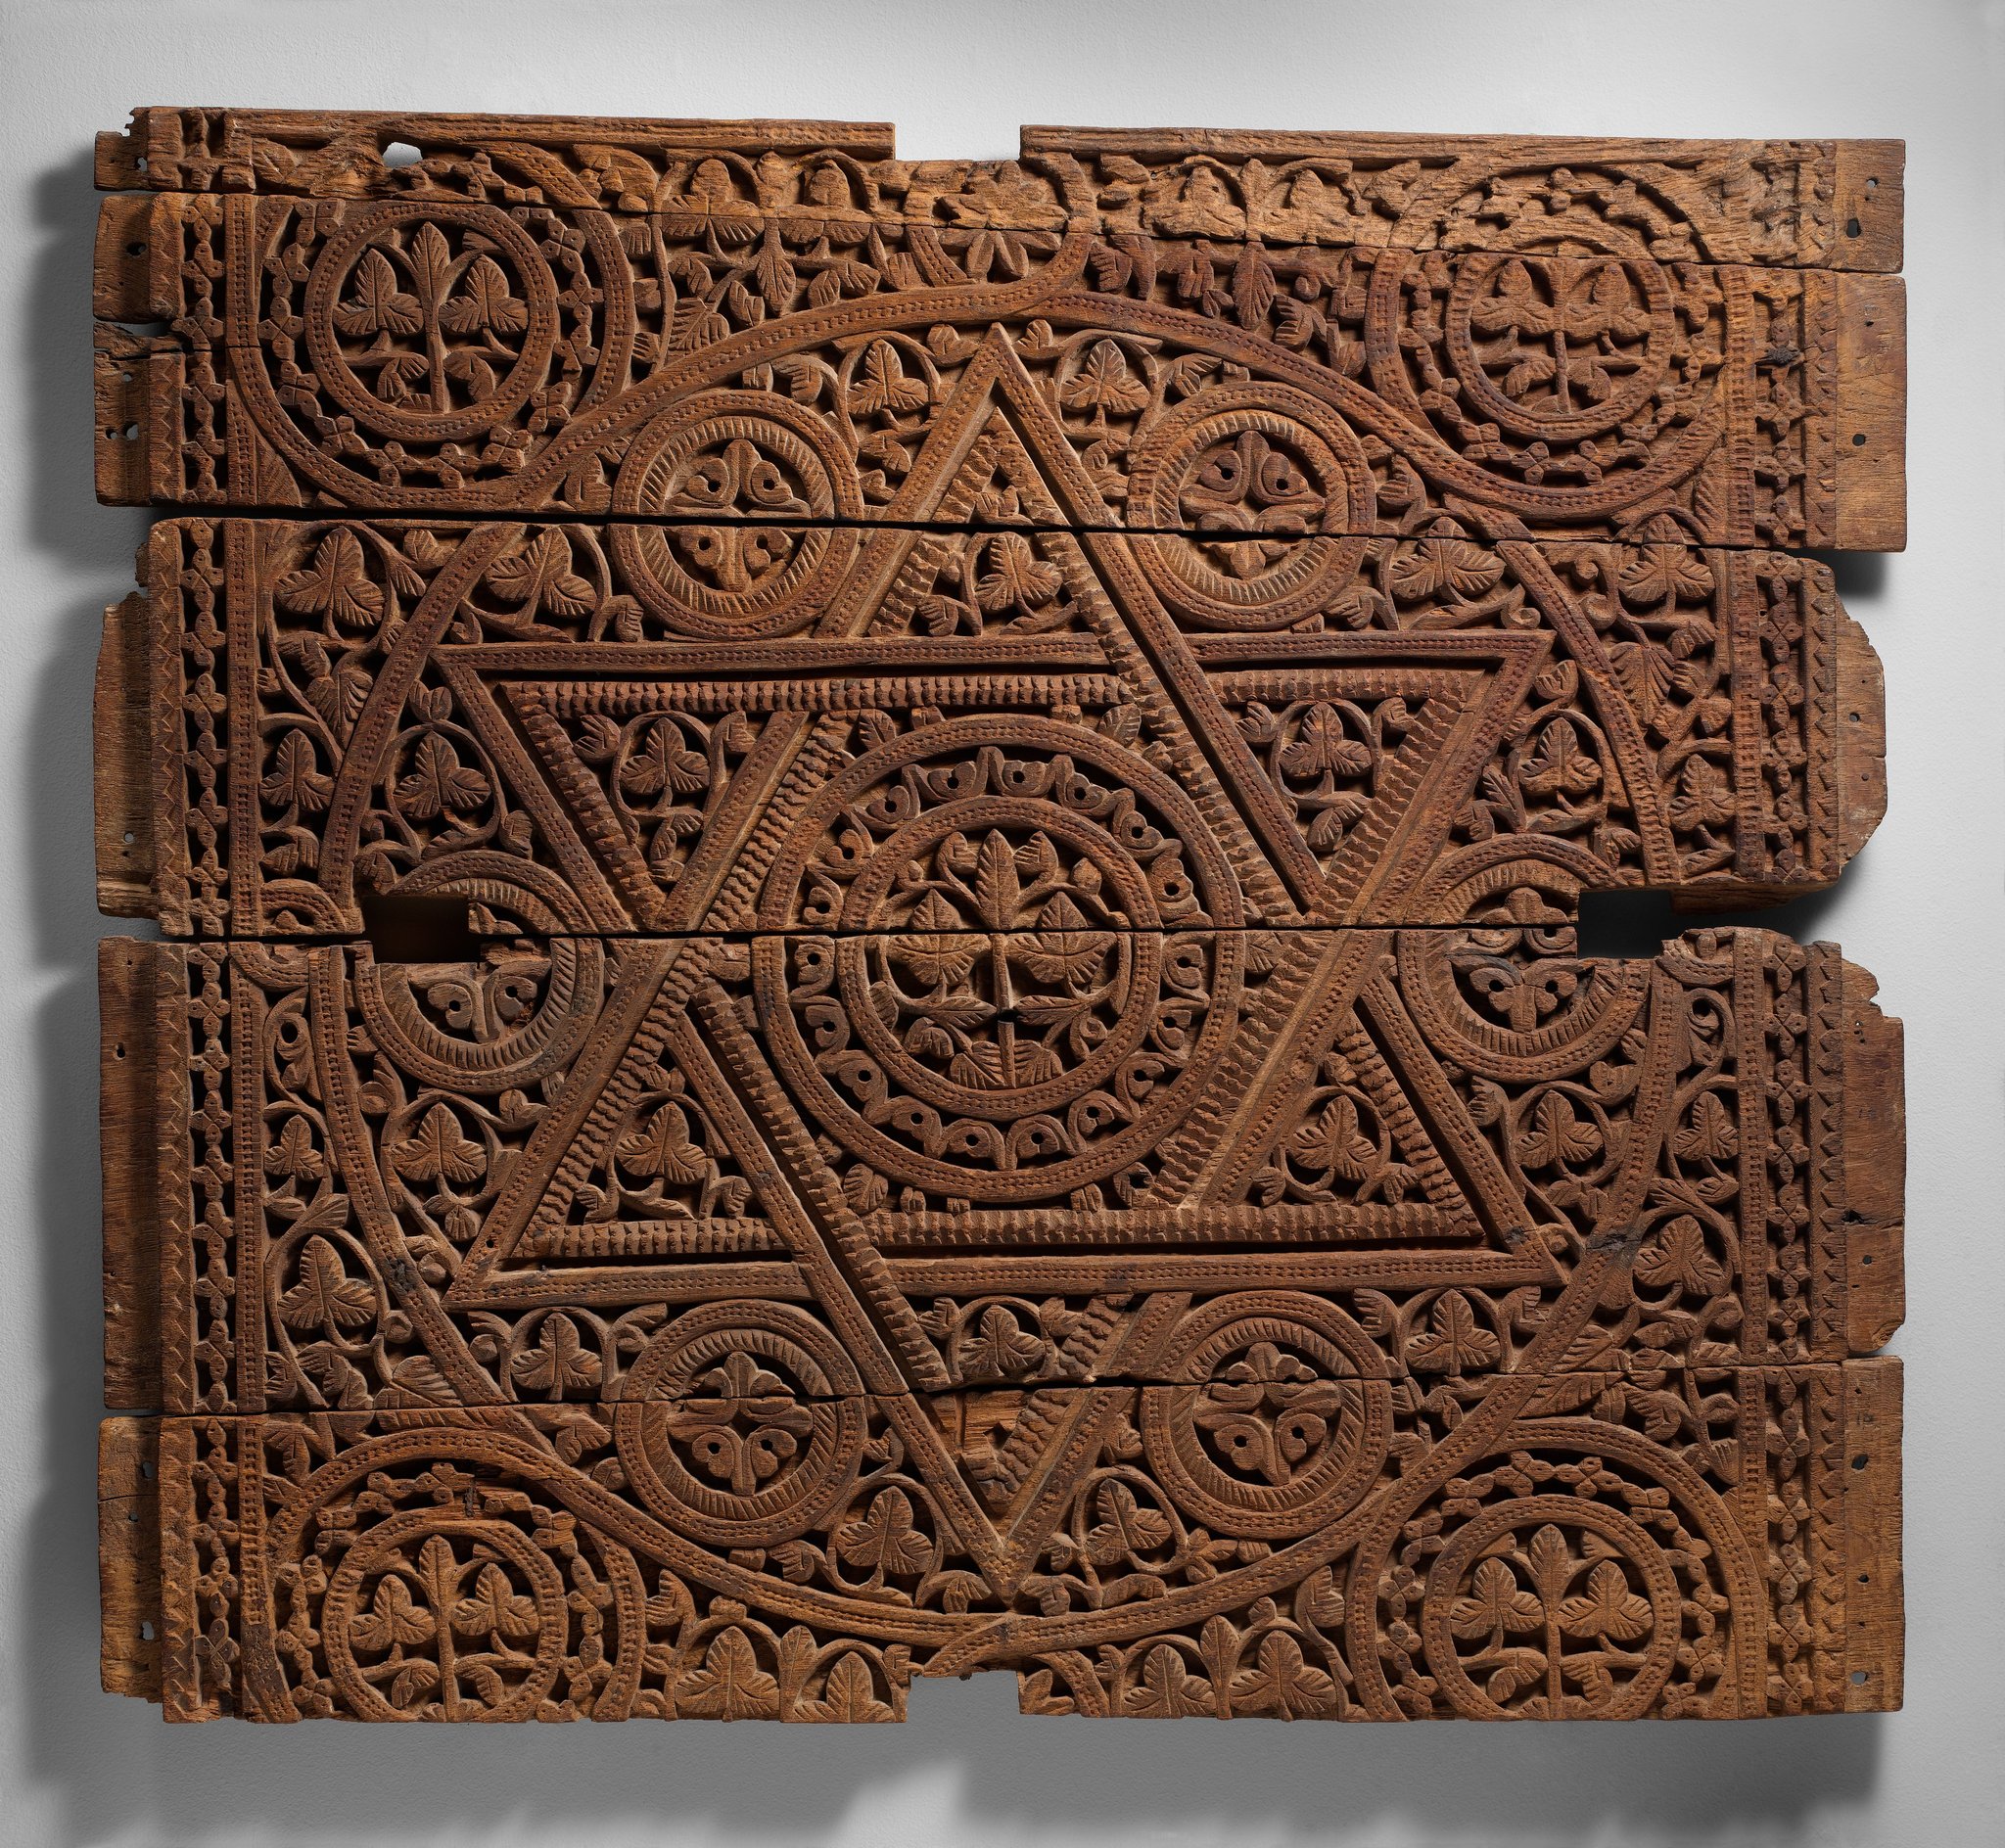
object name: panel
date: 801-833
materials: wood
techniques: carving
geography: iraq